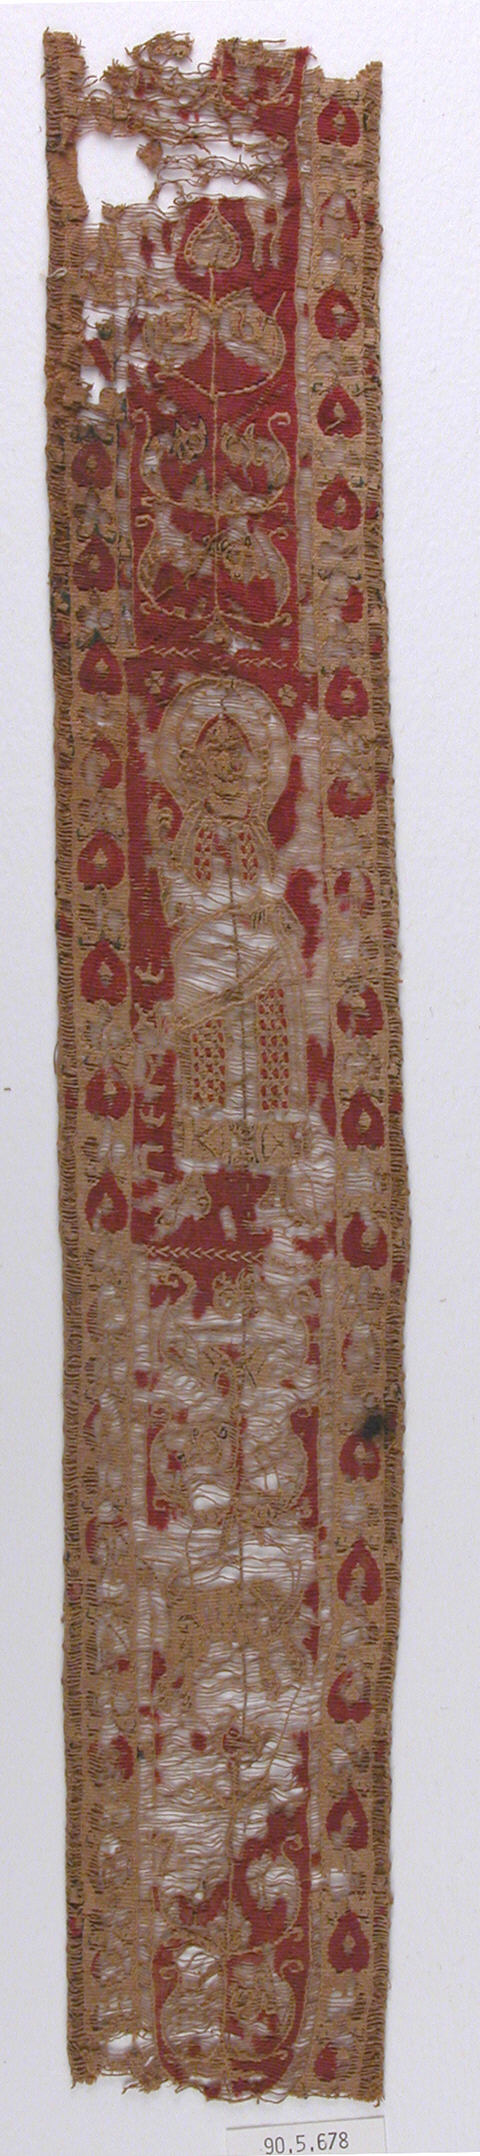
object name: textile fragment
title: Fragment of Shoulder Band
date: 401-600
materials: linen, wool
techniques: weave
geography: egypt